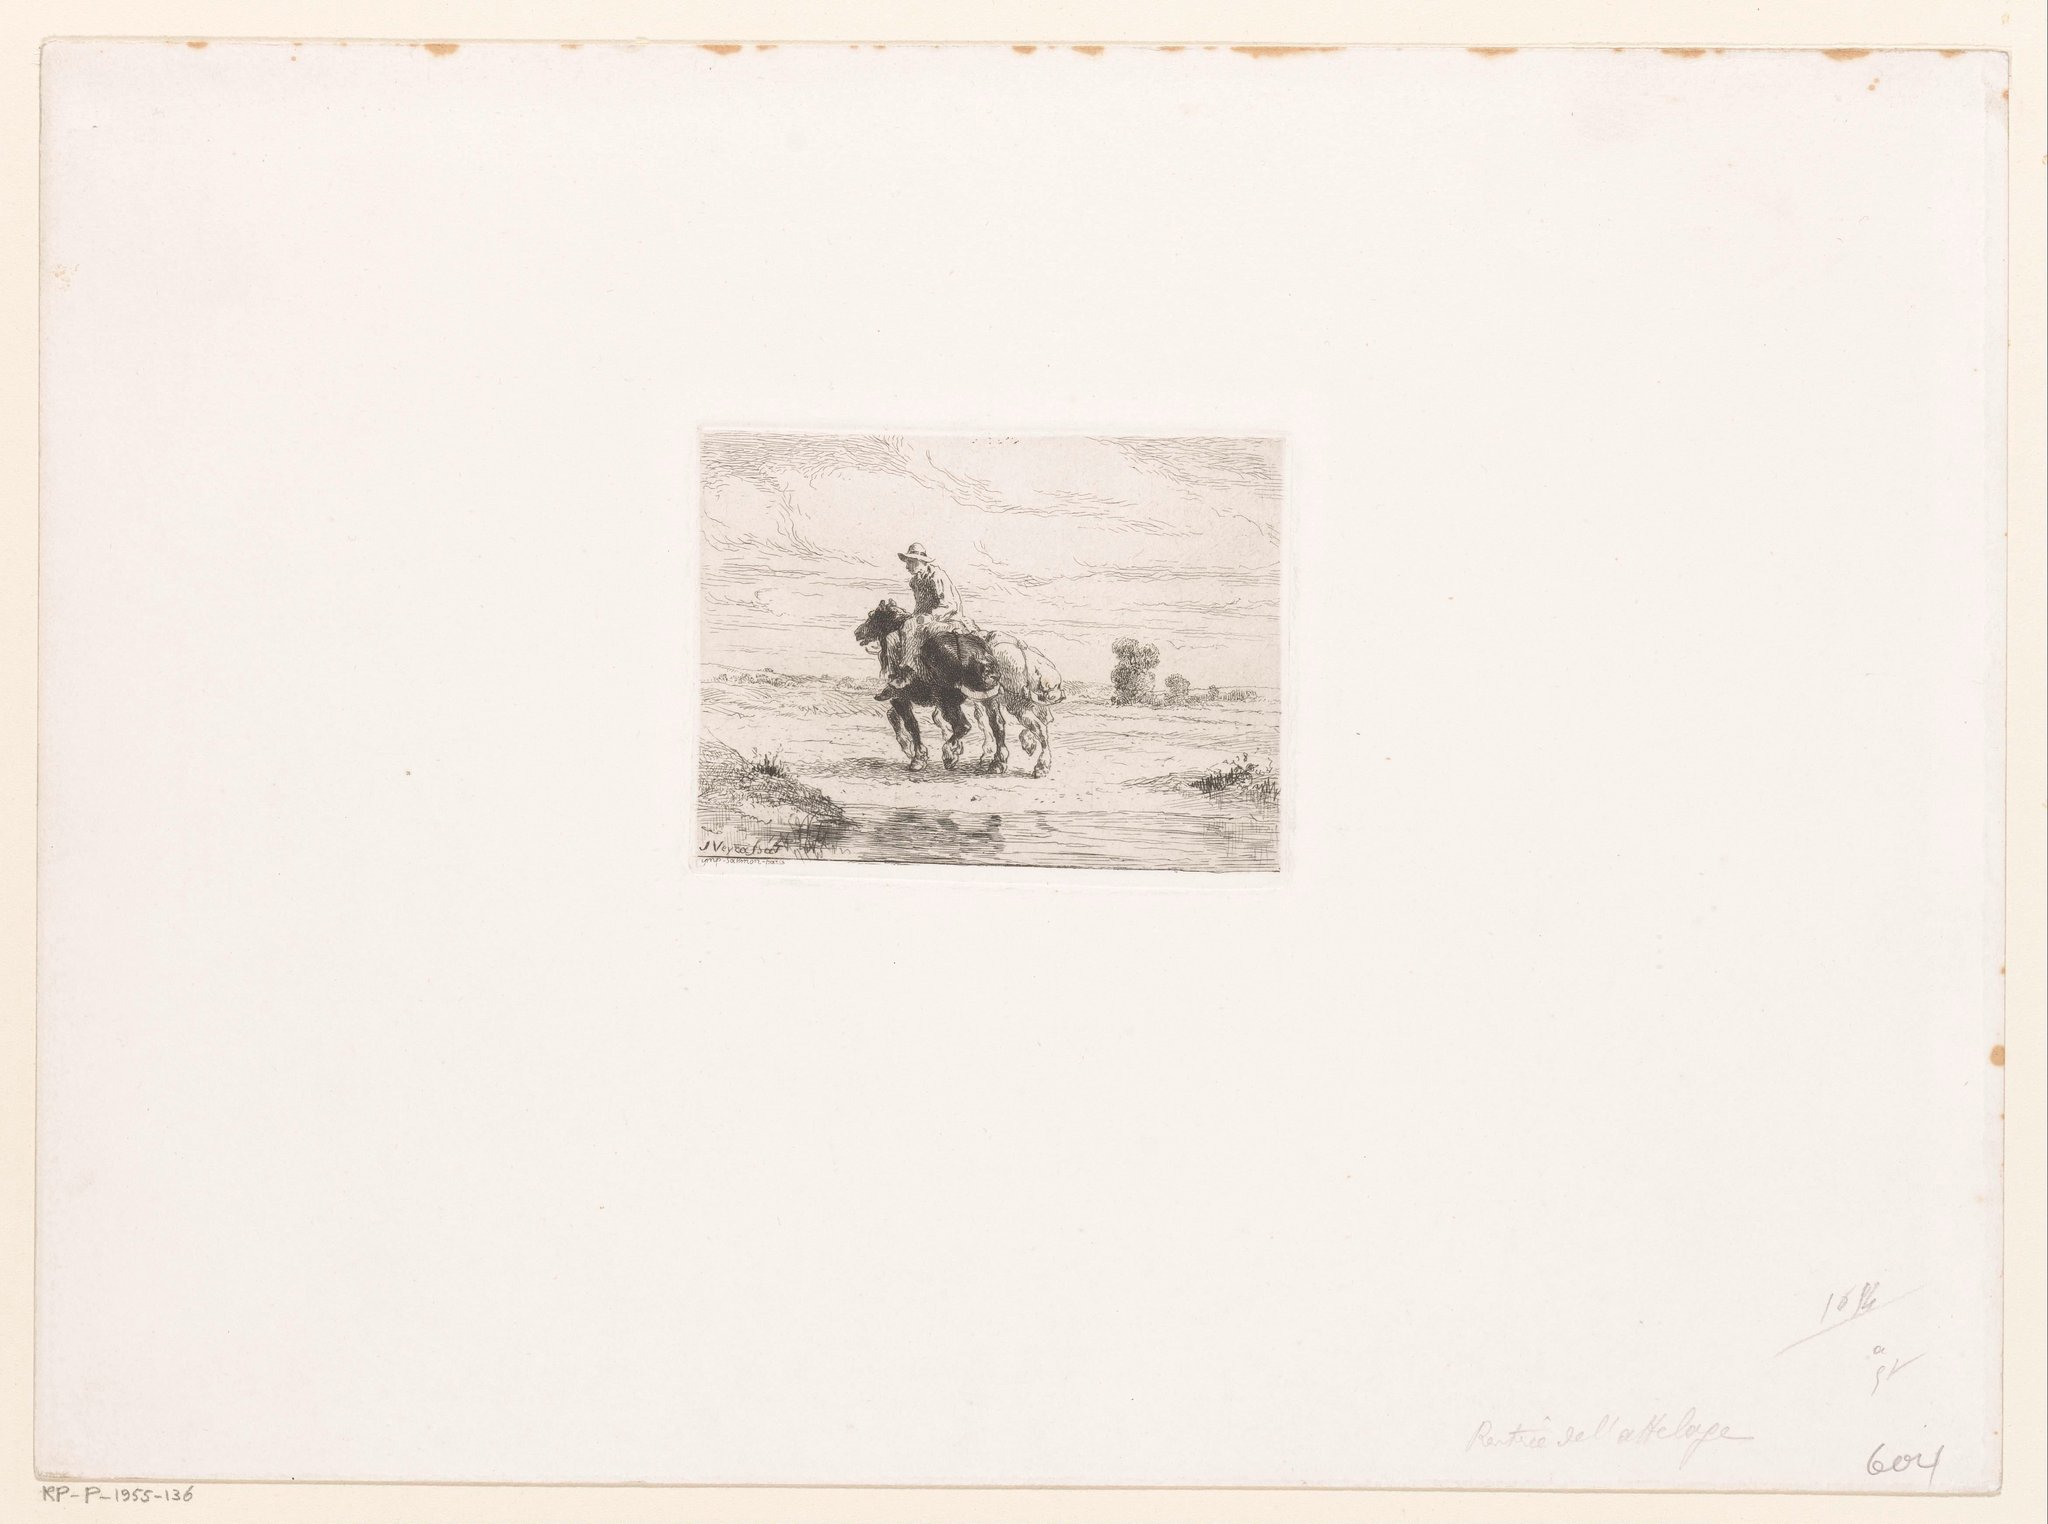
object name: print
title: Eaux-fortes par J. Veyrassat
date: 1866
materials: paper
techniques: drypoint, etching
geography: paris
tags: horse, landscapes (+ landscape with figures, staffage)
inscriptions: inscription: ‘Rentrée de l'attelage’, collector's mark: Lugt 2228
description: Maakt deel uit van een serie van veertien etsen door Jules Jacques Veyrassat, gepubliceerd in 1866 en beschreven door Beraldi 1885-1892.